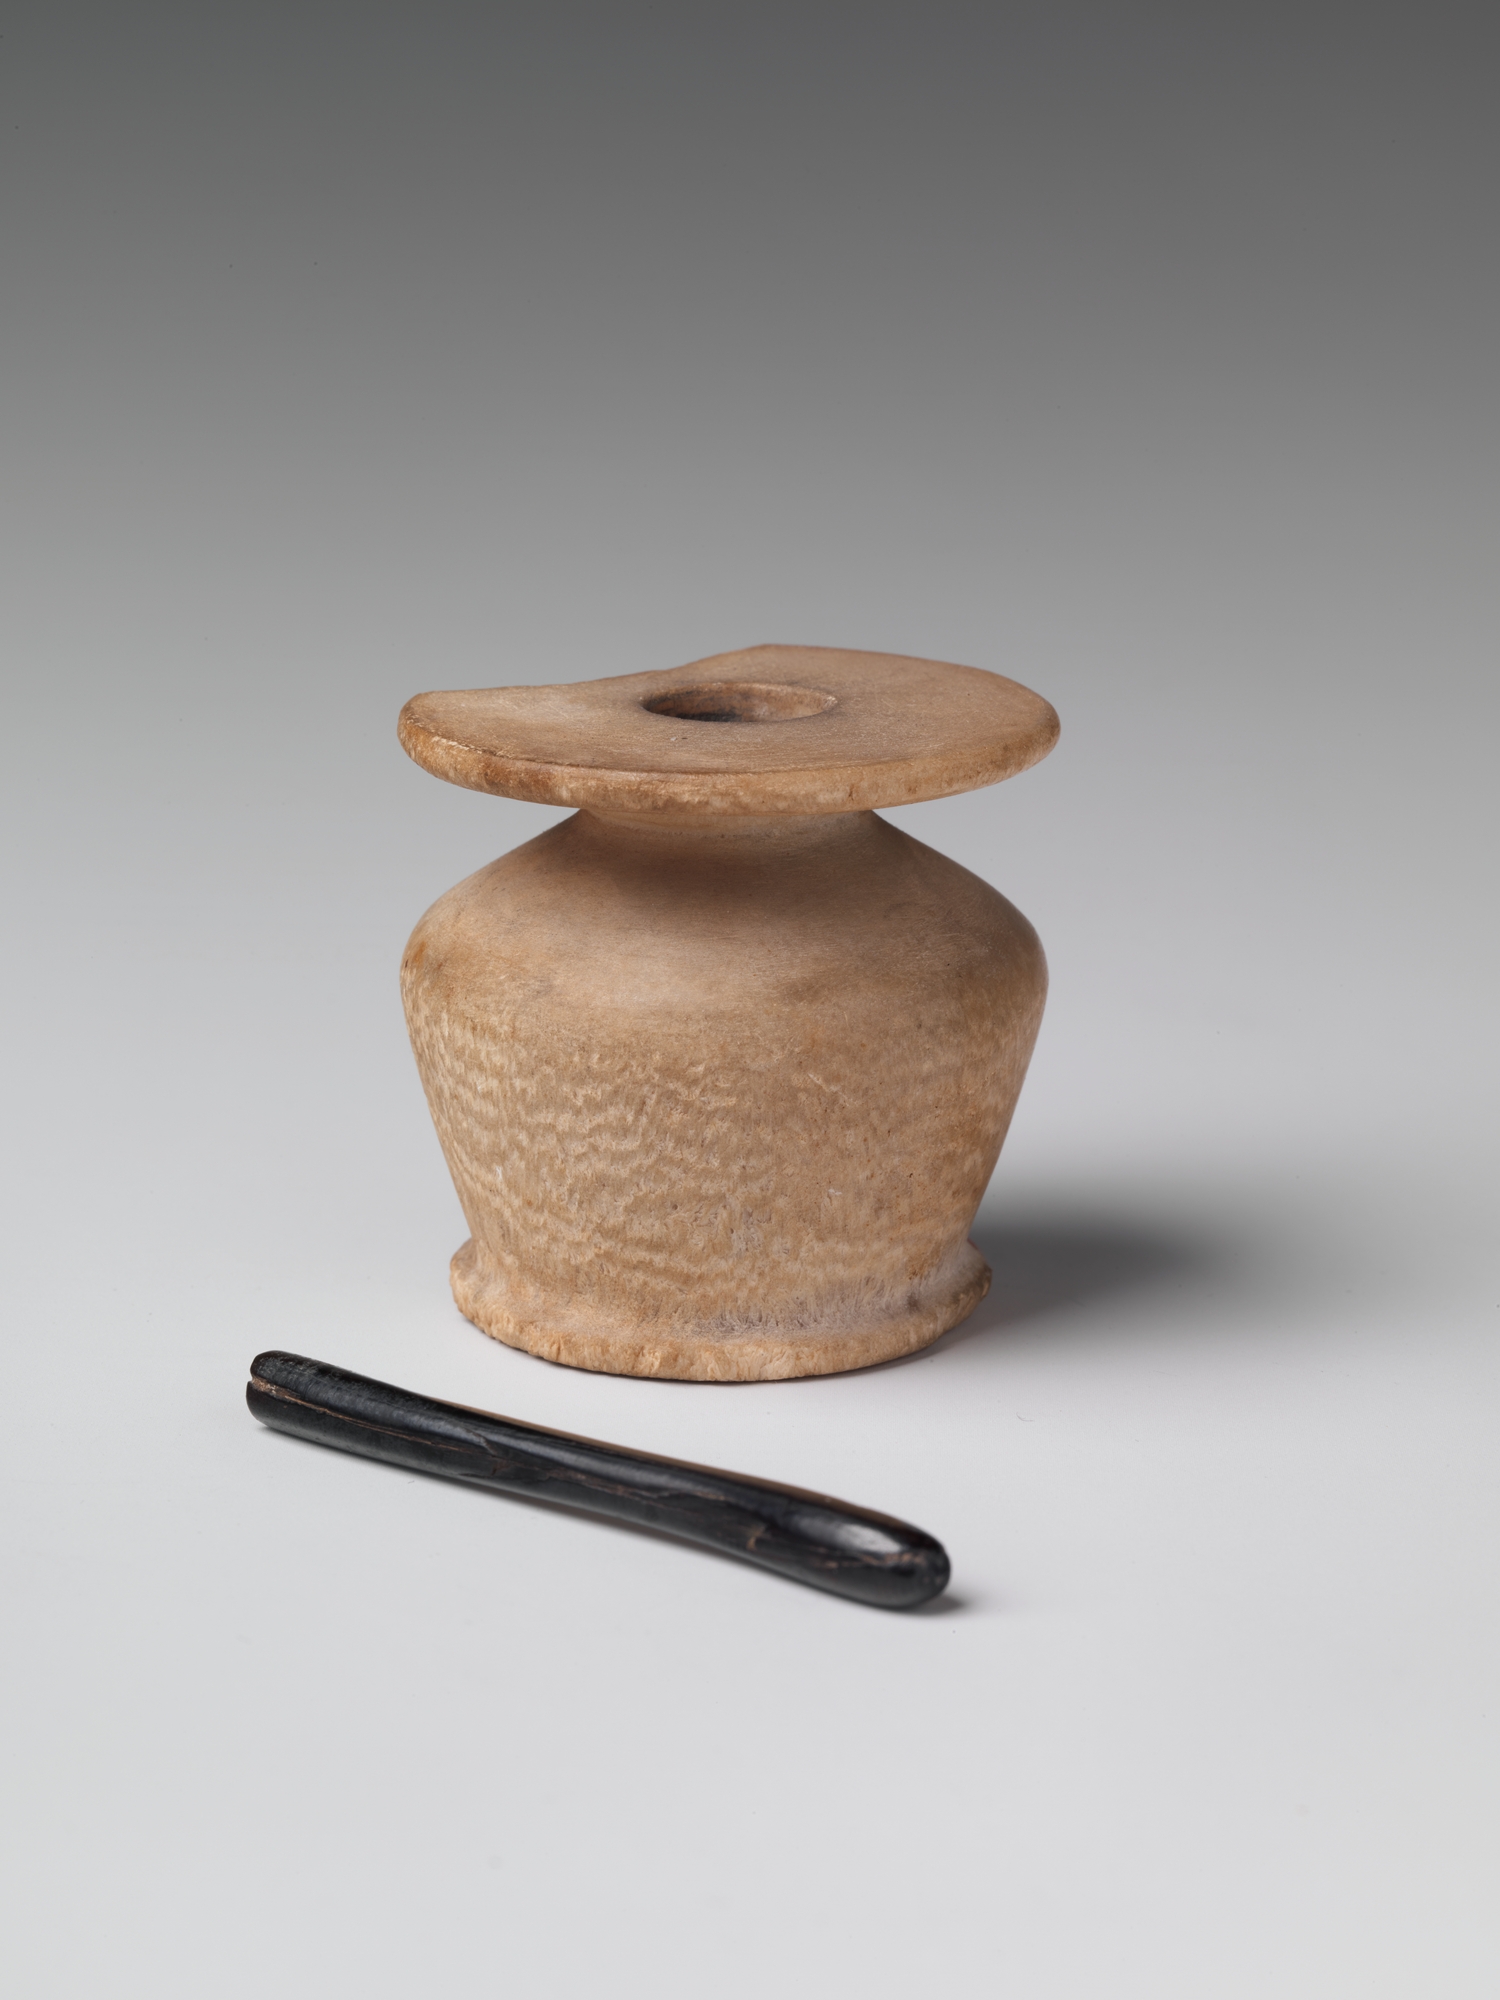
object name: kohl jar, stick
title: Kohl Jar and Stick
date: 1635-1458 BCE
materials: mineral, stone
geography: egypt